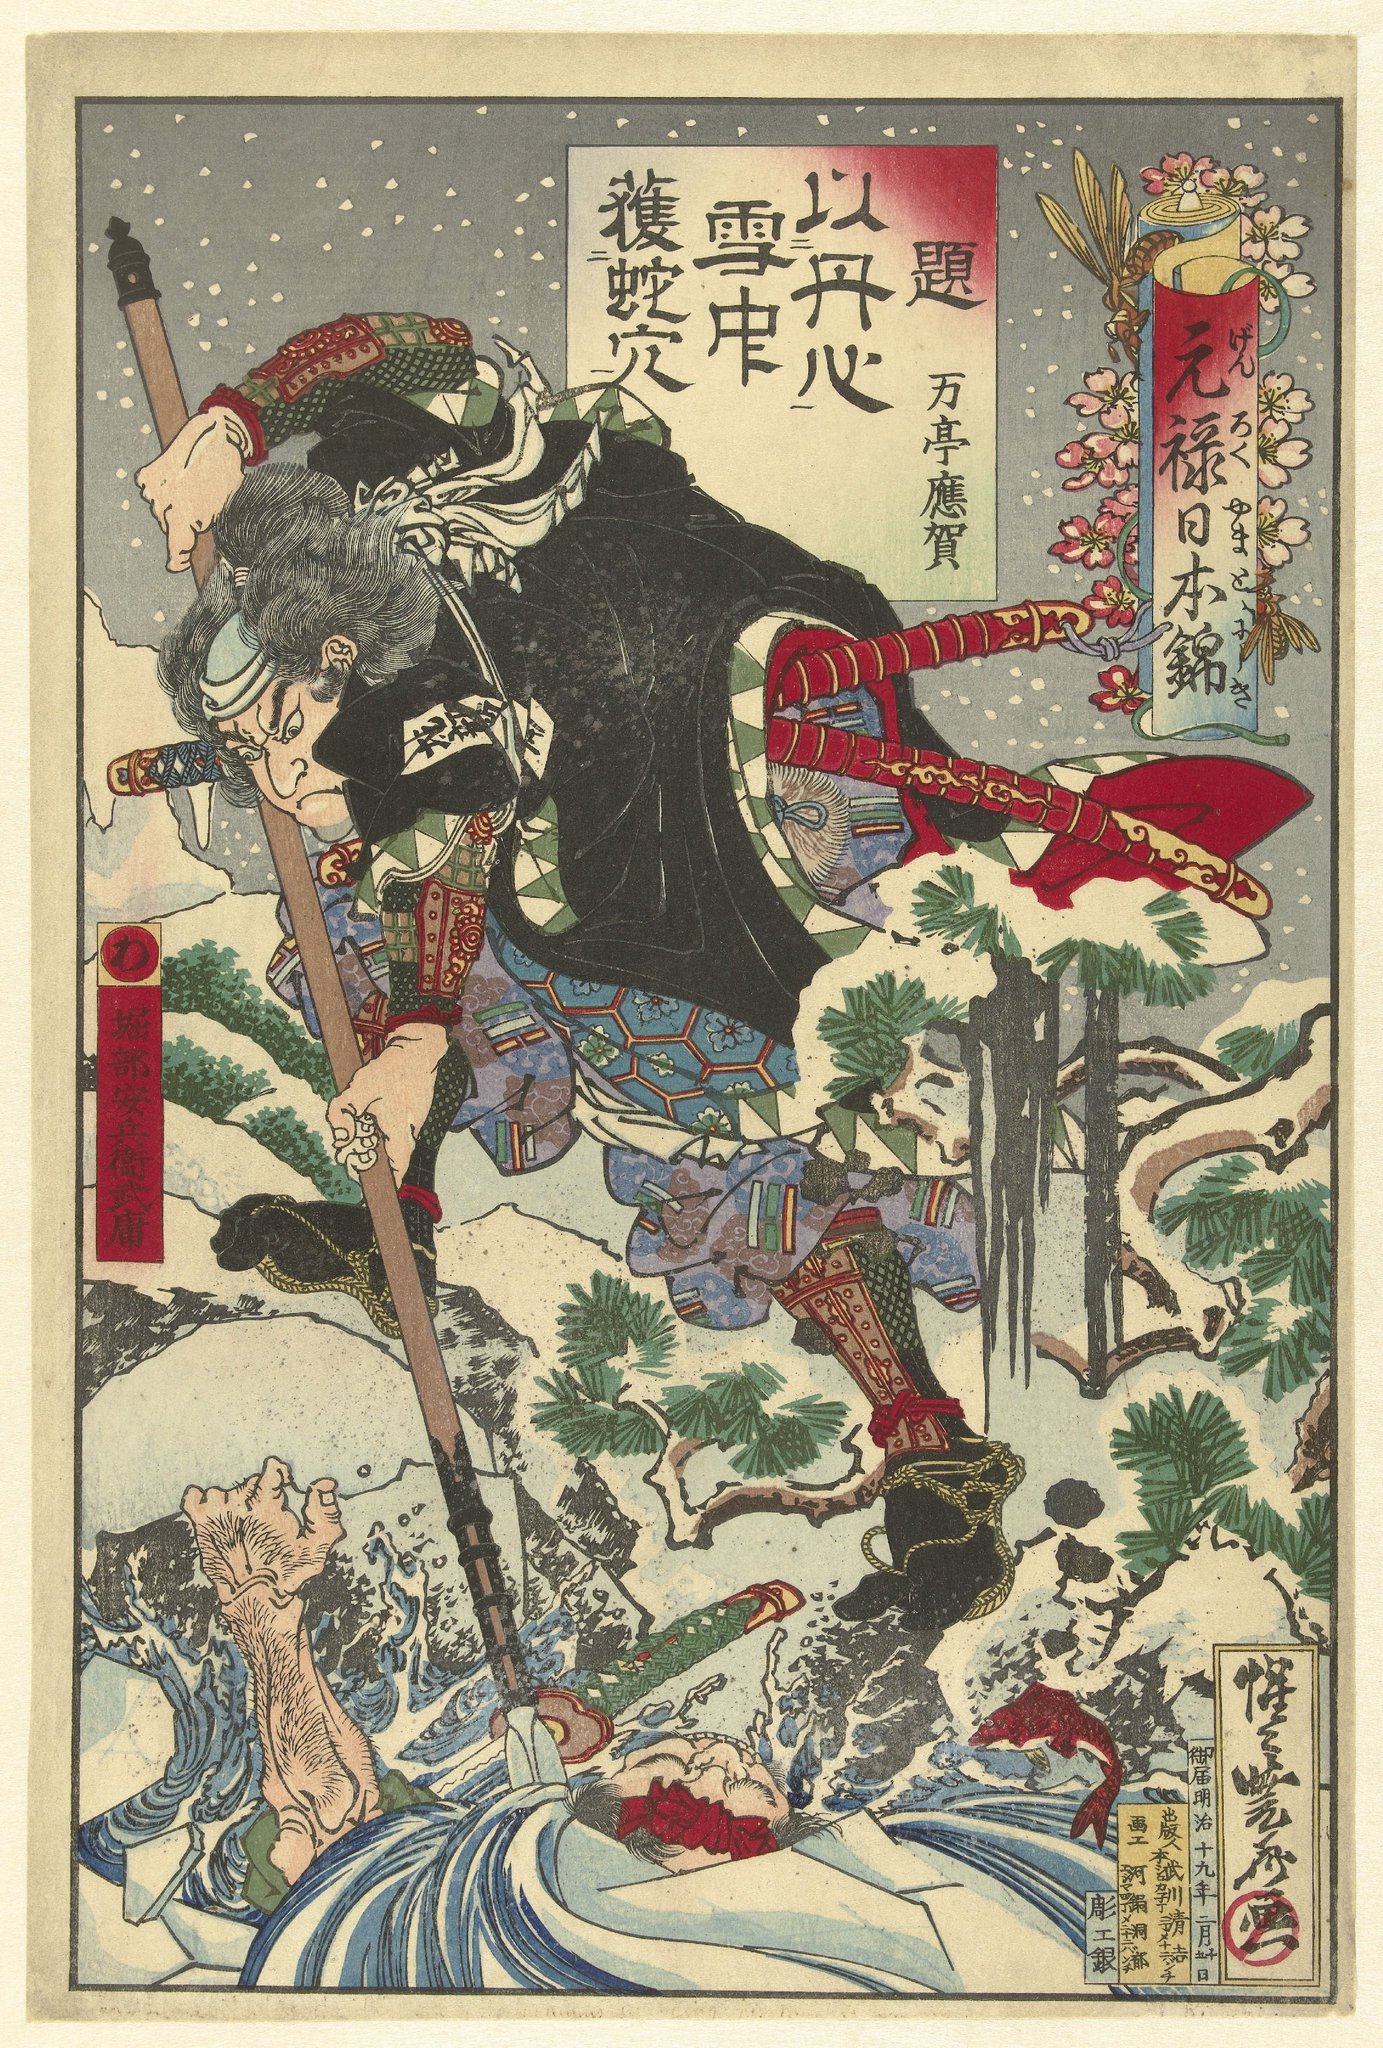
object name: print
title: Horibe Yasube Taketsune tijdens een nachtelijke aanval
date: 1886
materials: paper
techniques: woodcut, nishiki e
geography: japan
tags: snow, fighting, violent death by lance, spear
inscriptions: collector's mark: Lugt 2228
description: Horibe Yasube Taketsune met speer een tegenstander in een bevroren meer duwend; in sneeuwlandschap bij nacht.